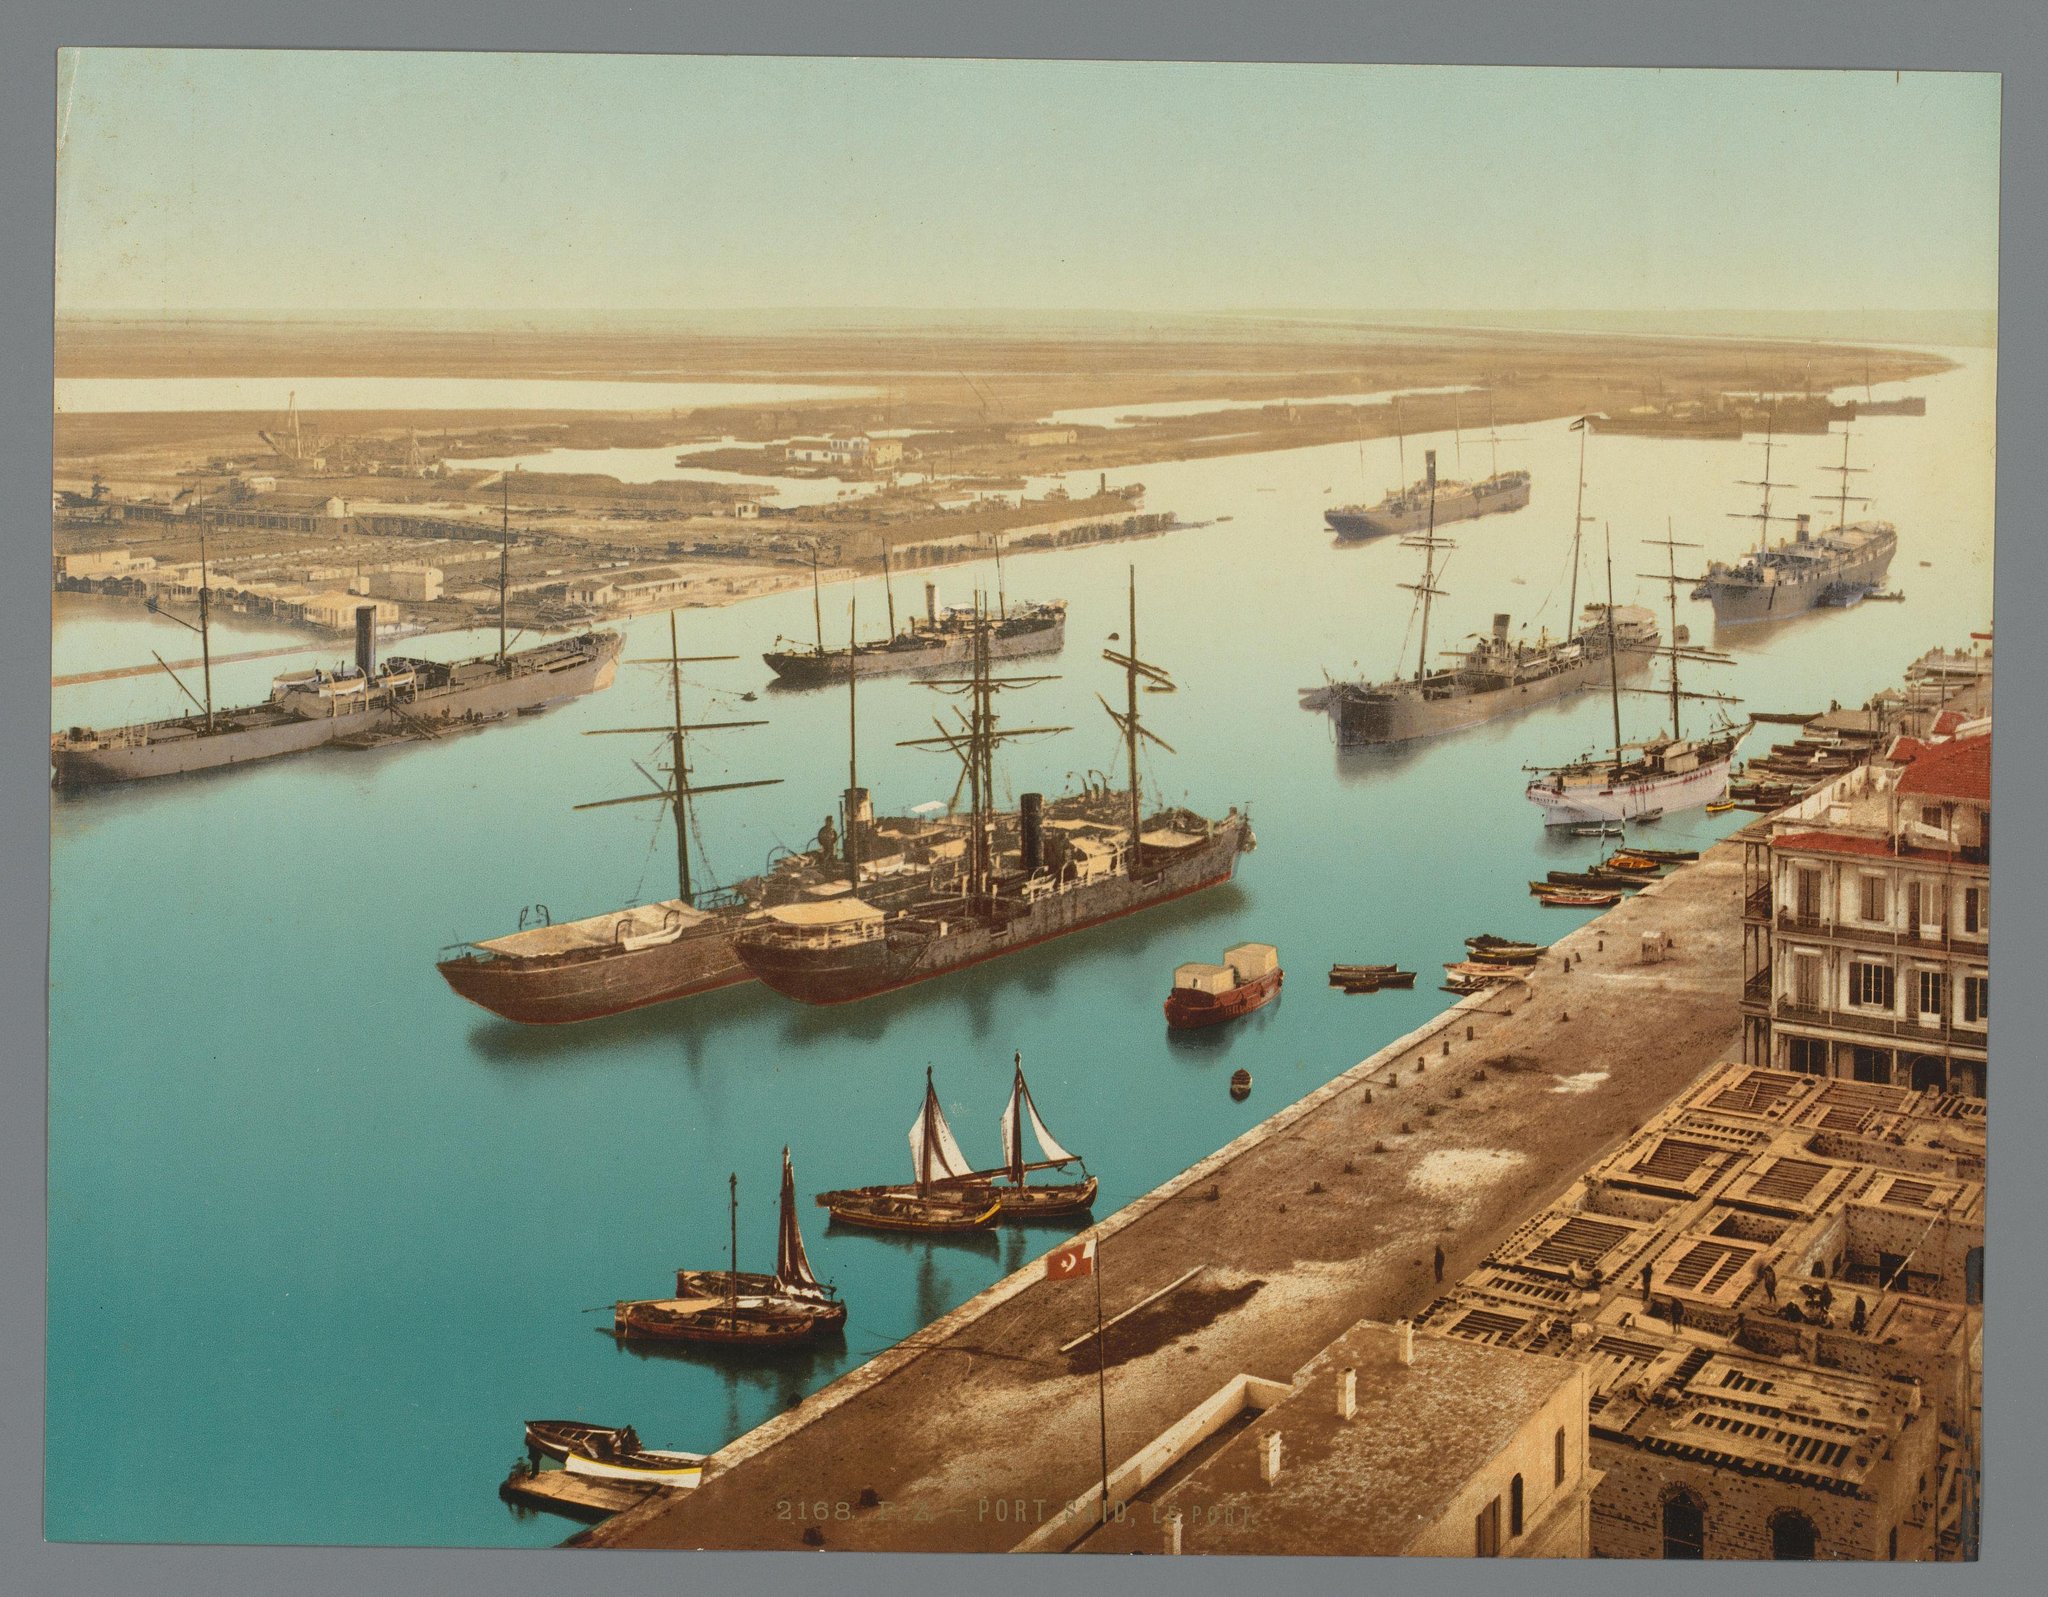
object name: photomechanical print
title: Gezicht op het Suezkanaal in Port Said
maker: Anonymous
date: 1889-1920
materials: paper, photographic process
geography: port said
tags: harbour, canal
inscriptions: number: ‘2168.’